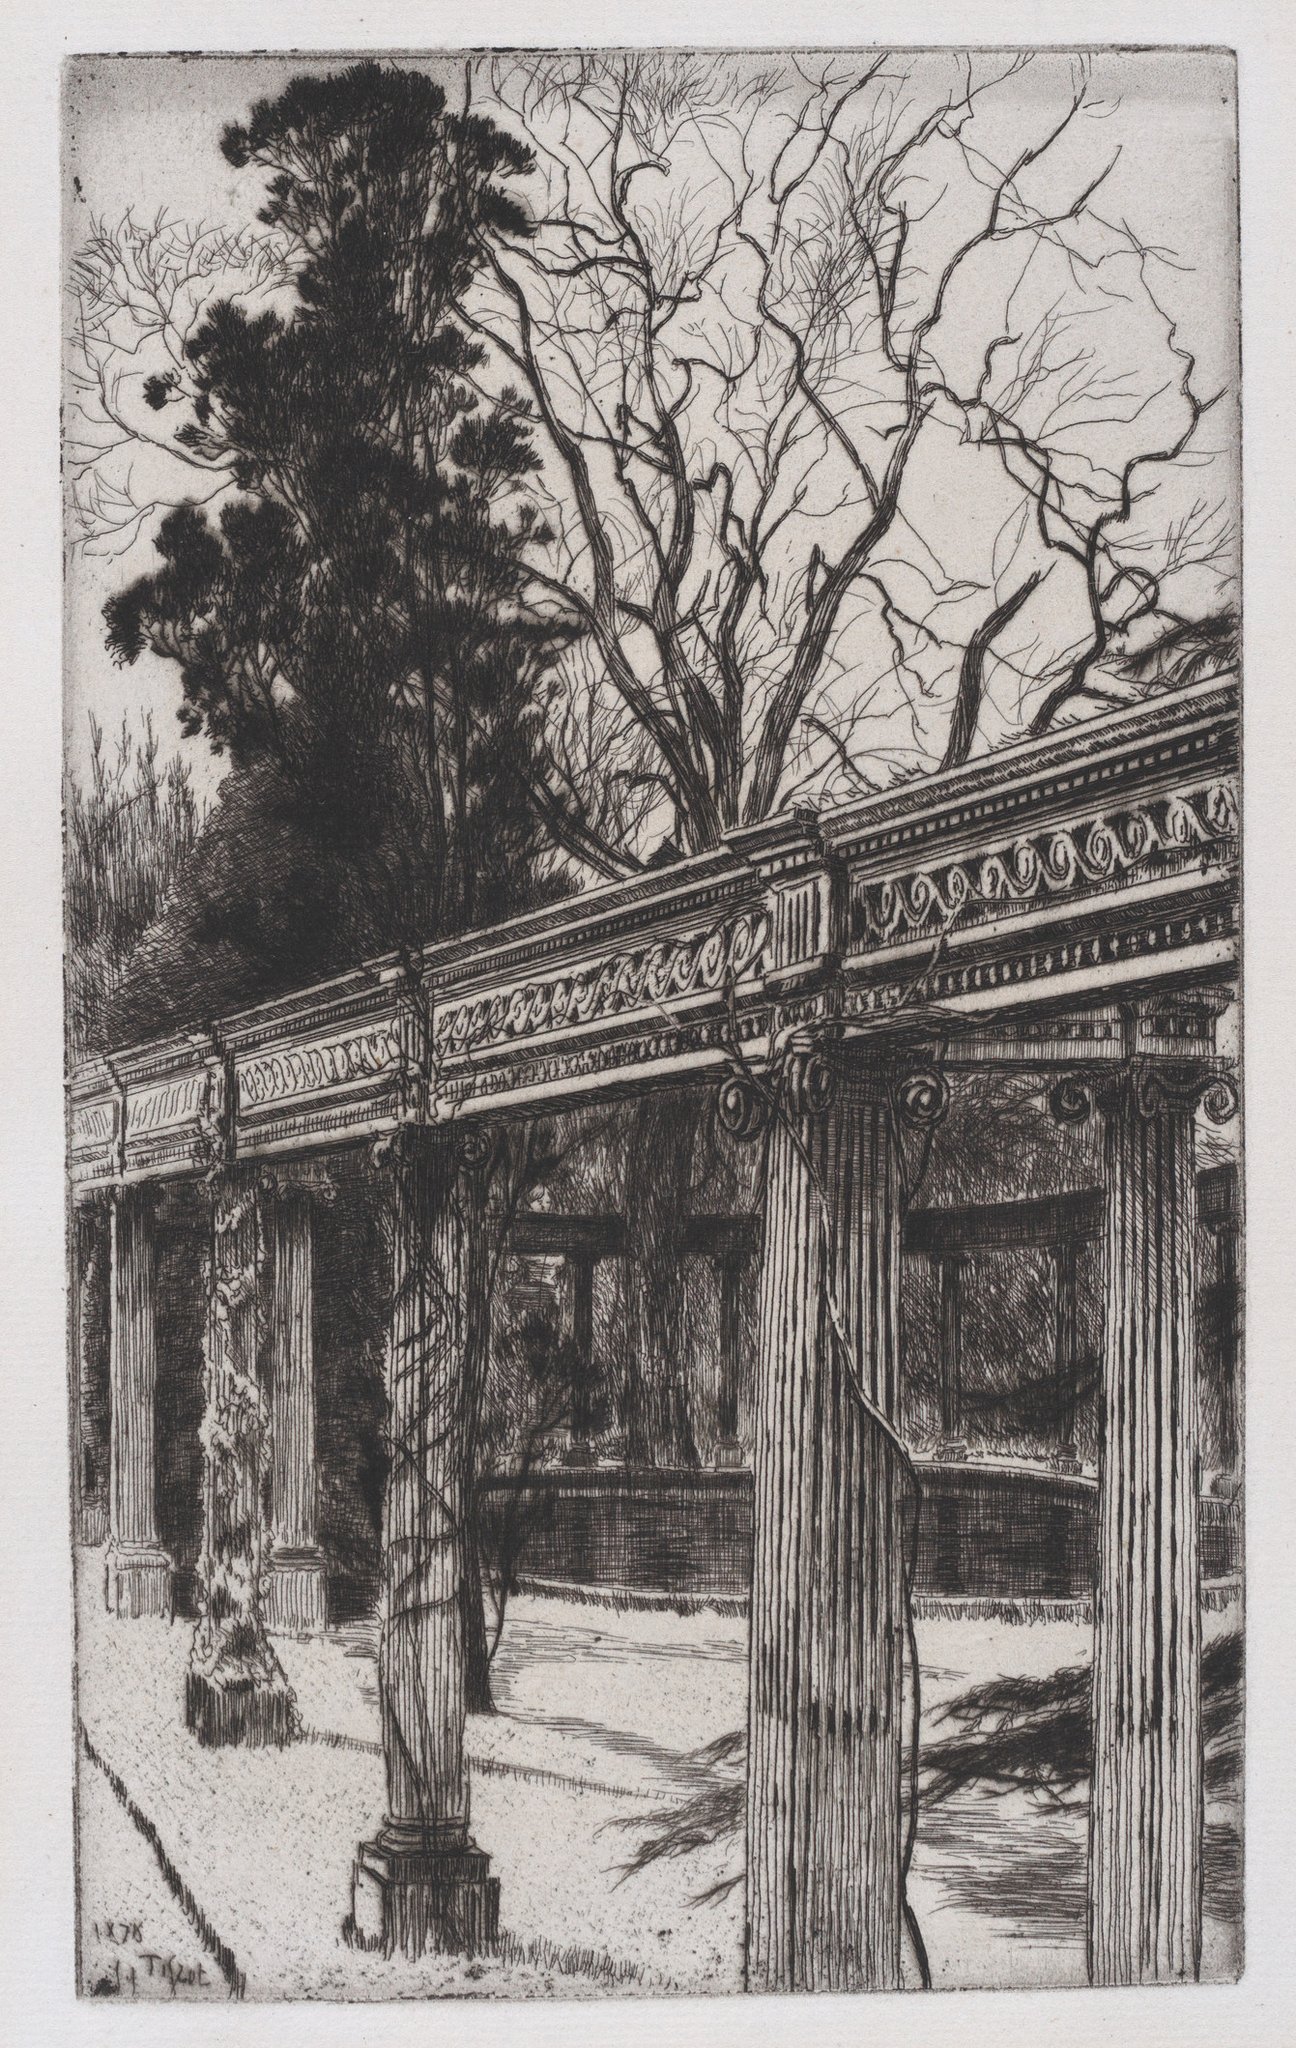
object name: print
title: My Garden in St. John’s Wood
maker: james tissot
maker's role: artist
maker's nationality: french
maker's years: 1836-1902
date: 1878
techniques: drypoint, etching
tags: columns,gardens